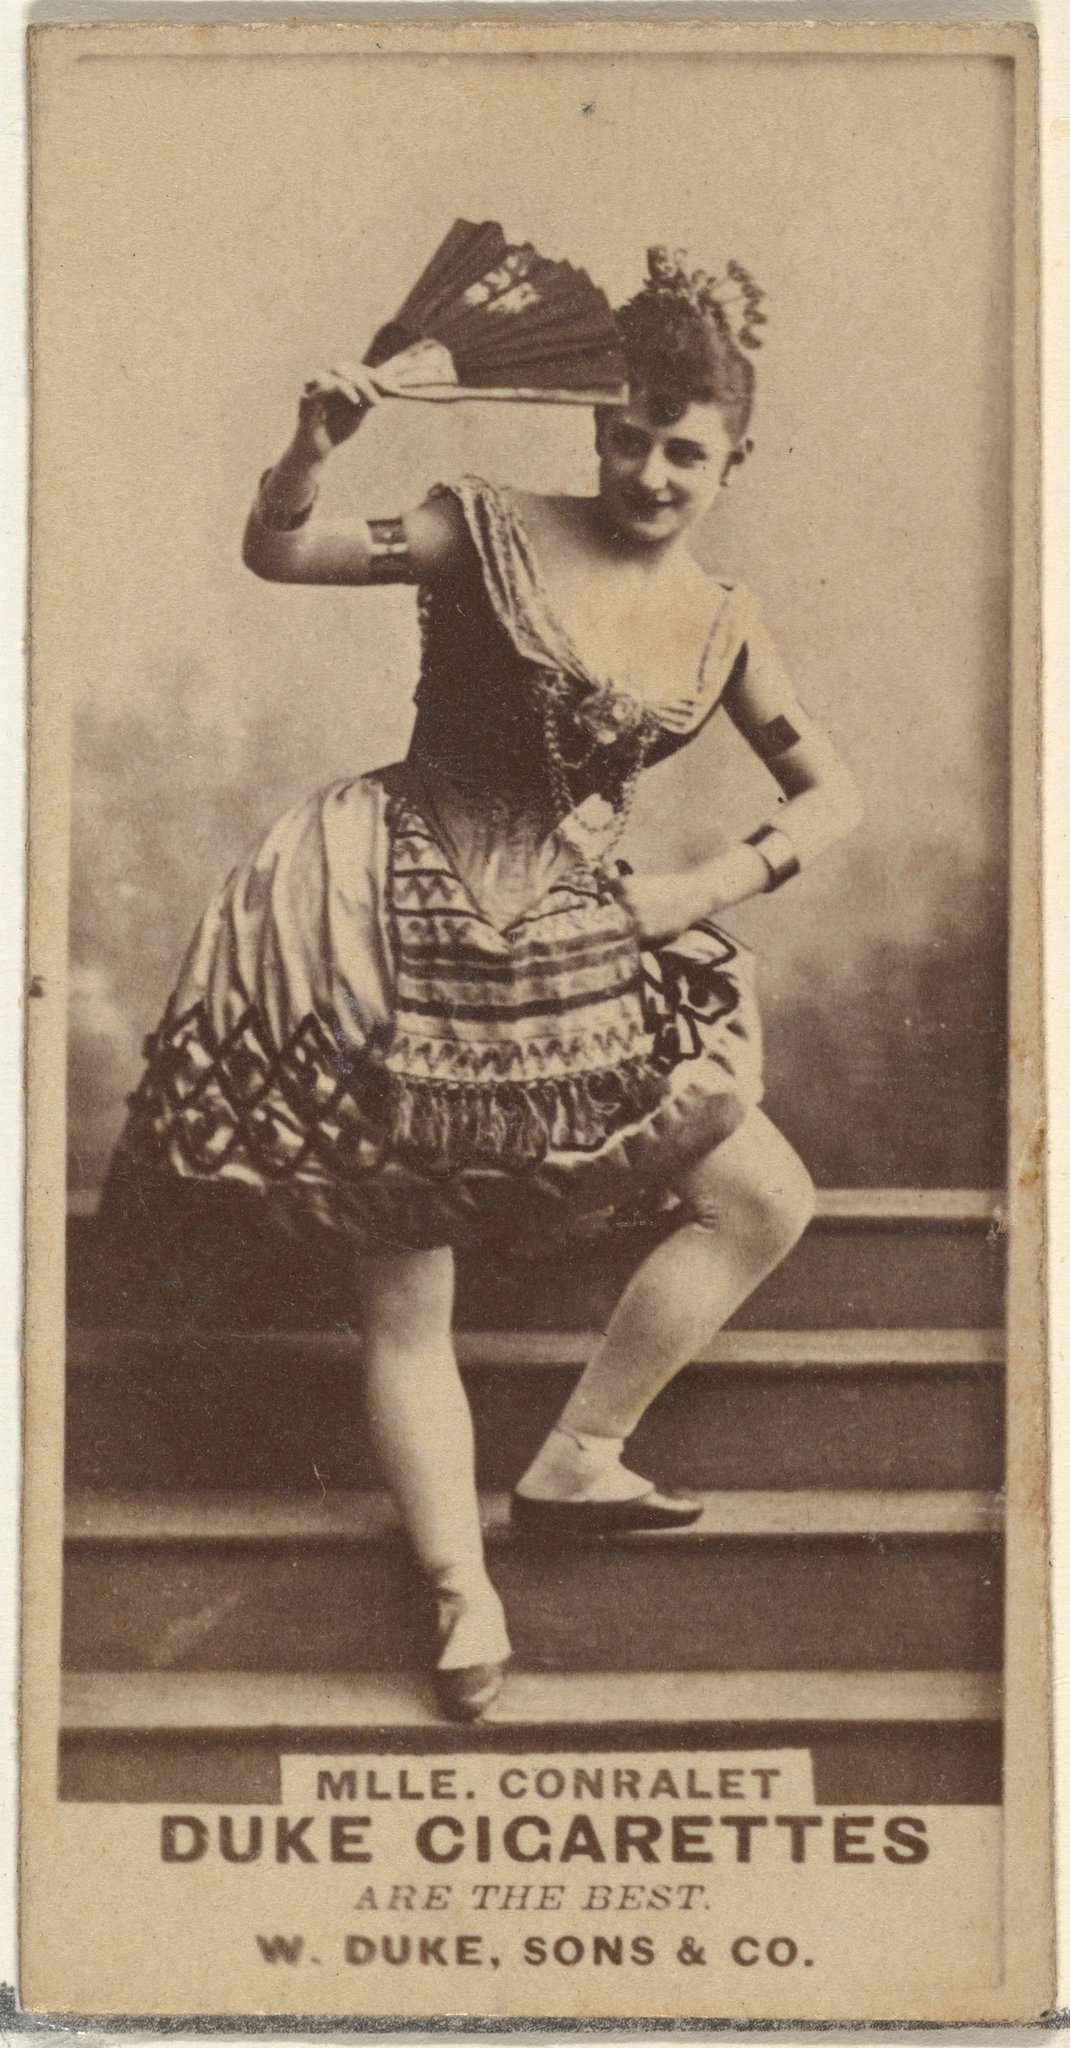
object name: photograph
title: Mlle. Conralet, from the Actors and Actresses series (N145-7) issued by Duke Sons & Co. to promote Duke Cigarettes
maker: w. duke, sons & co.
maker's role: publisher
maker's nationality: american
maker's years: 1870-1920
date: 1880-1889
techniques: albumen silver print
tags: fans,portraits,women,actresses